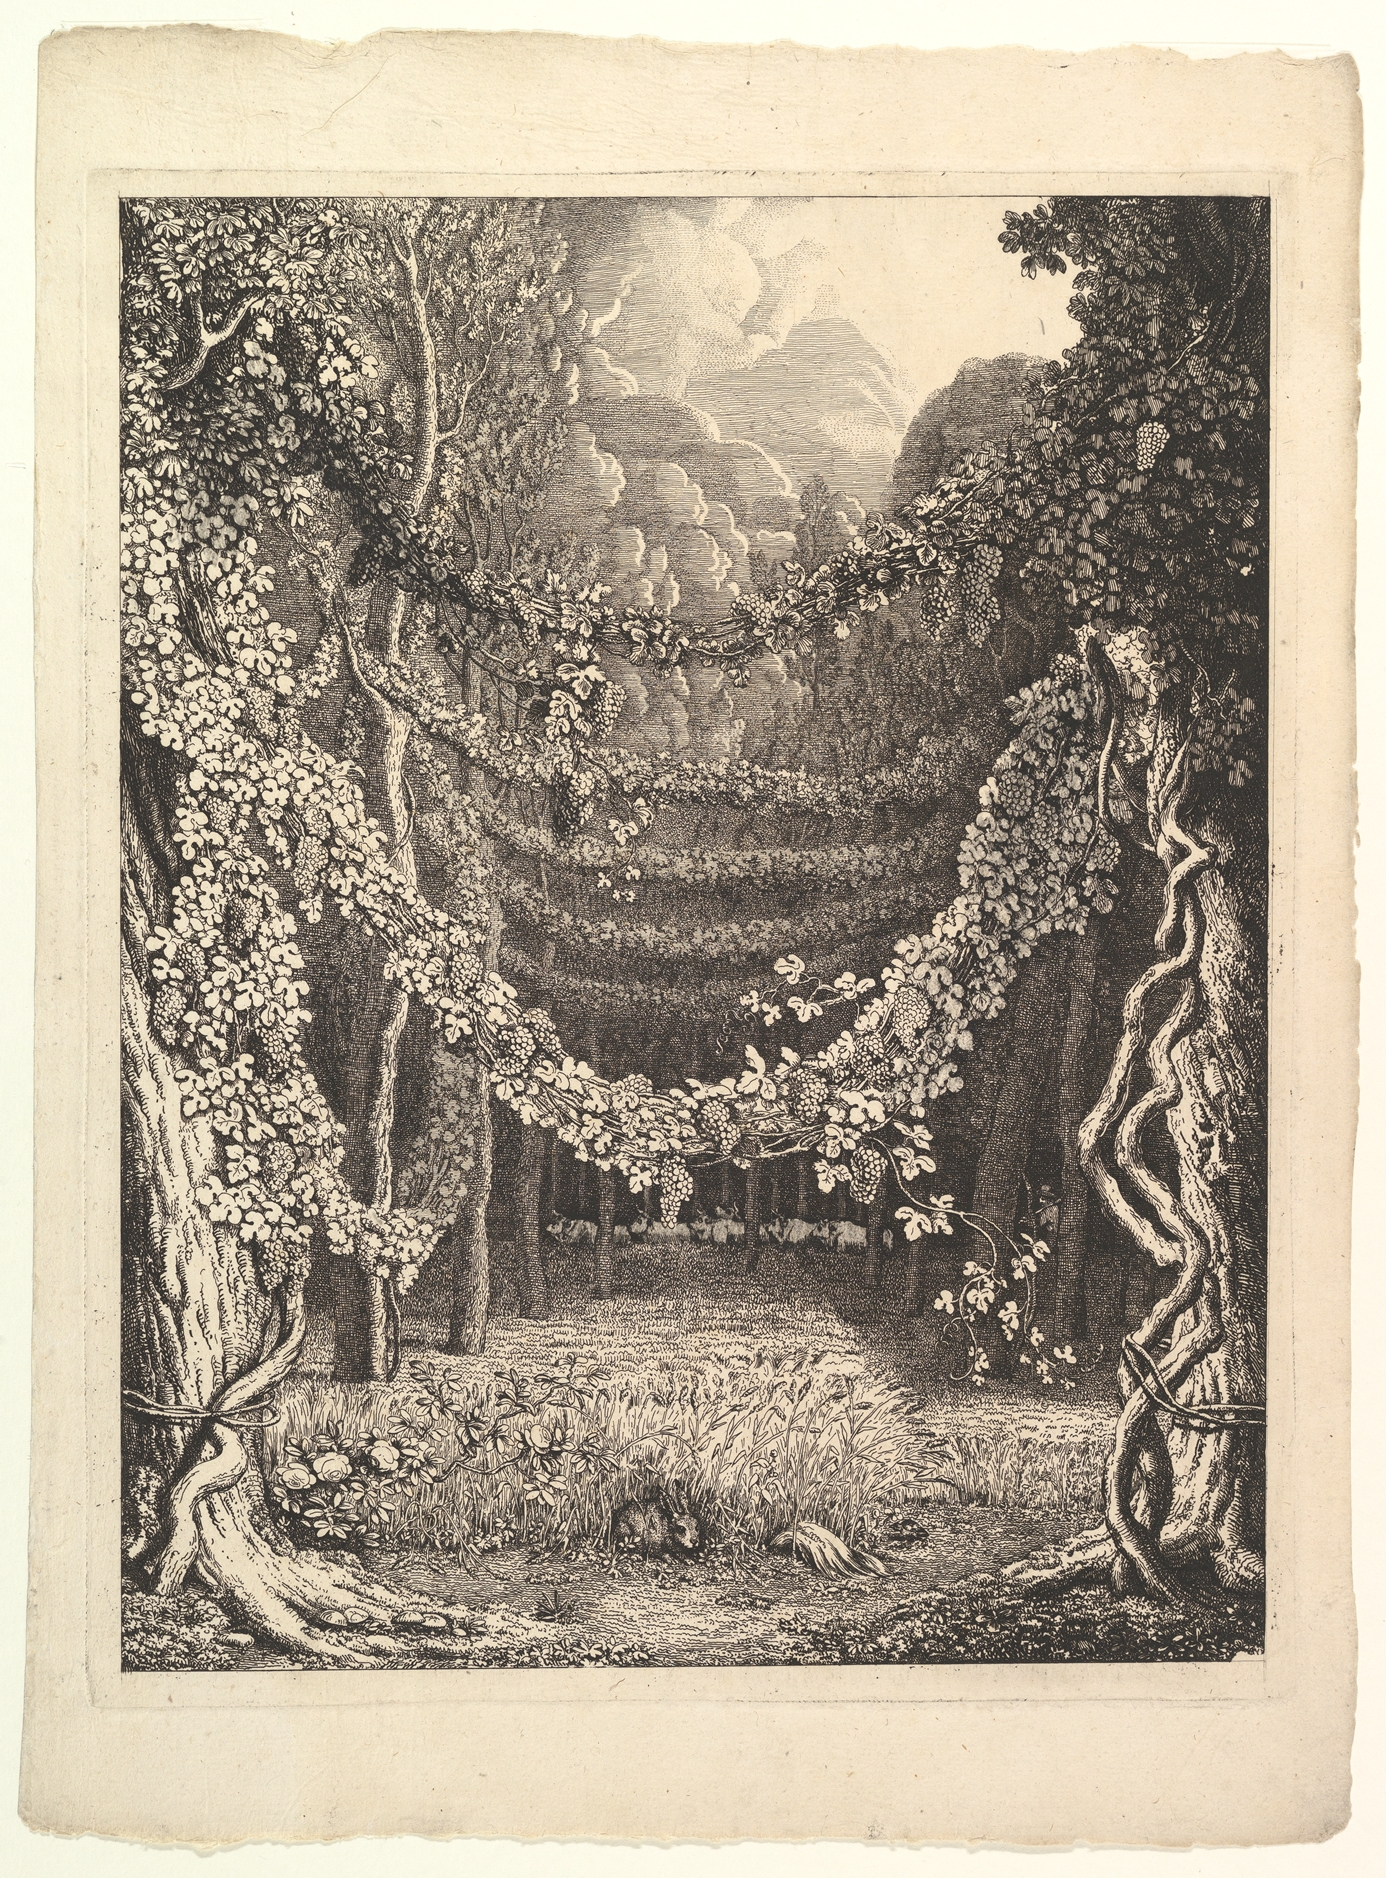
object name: print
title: Frontispiece for Heft IV of "Homer nach Antiken gezeichnet", Göttingen: Heinrich Dieterik, 1801–05 and Stuttgart: J. G. Cotta, 1821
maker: johann heinrich wilhelm tischbein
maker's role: artist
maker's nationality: german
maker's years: 1751-1829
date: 1796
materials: chalk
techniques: etching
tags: garlands,trees